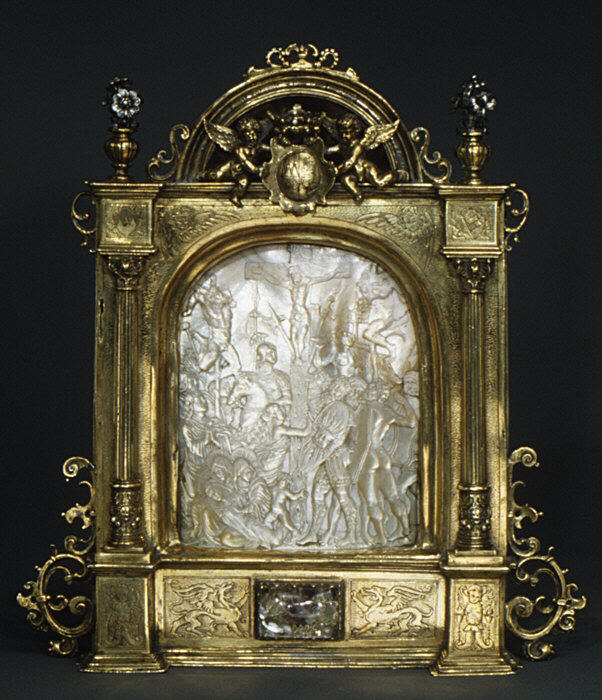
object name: pax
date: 1801-1900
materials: mother of pearl, silver gilt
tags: angels,cross,jesus,crucifixion